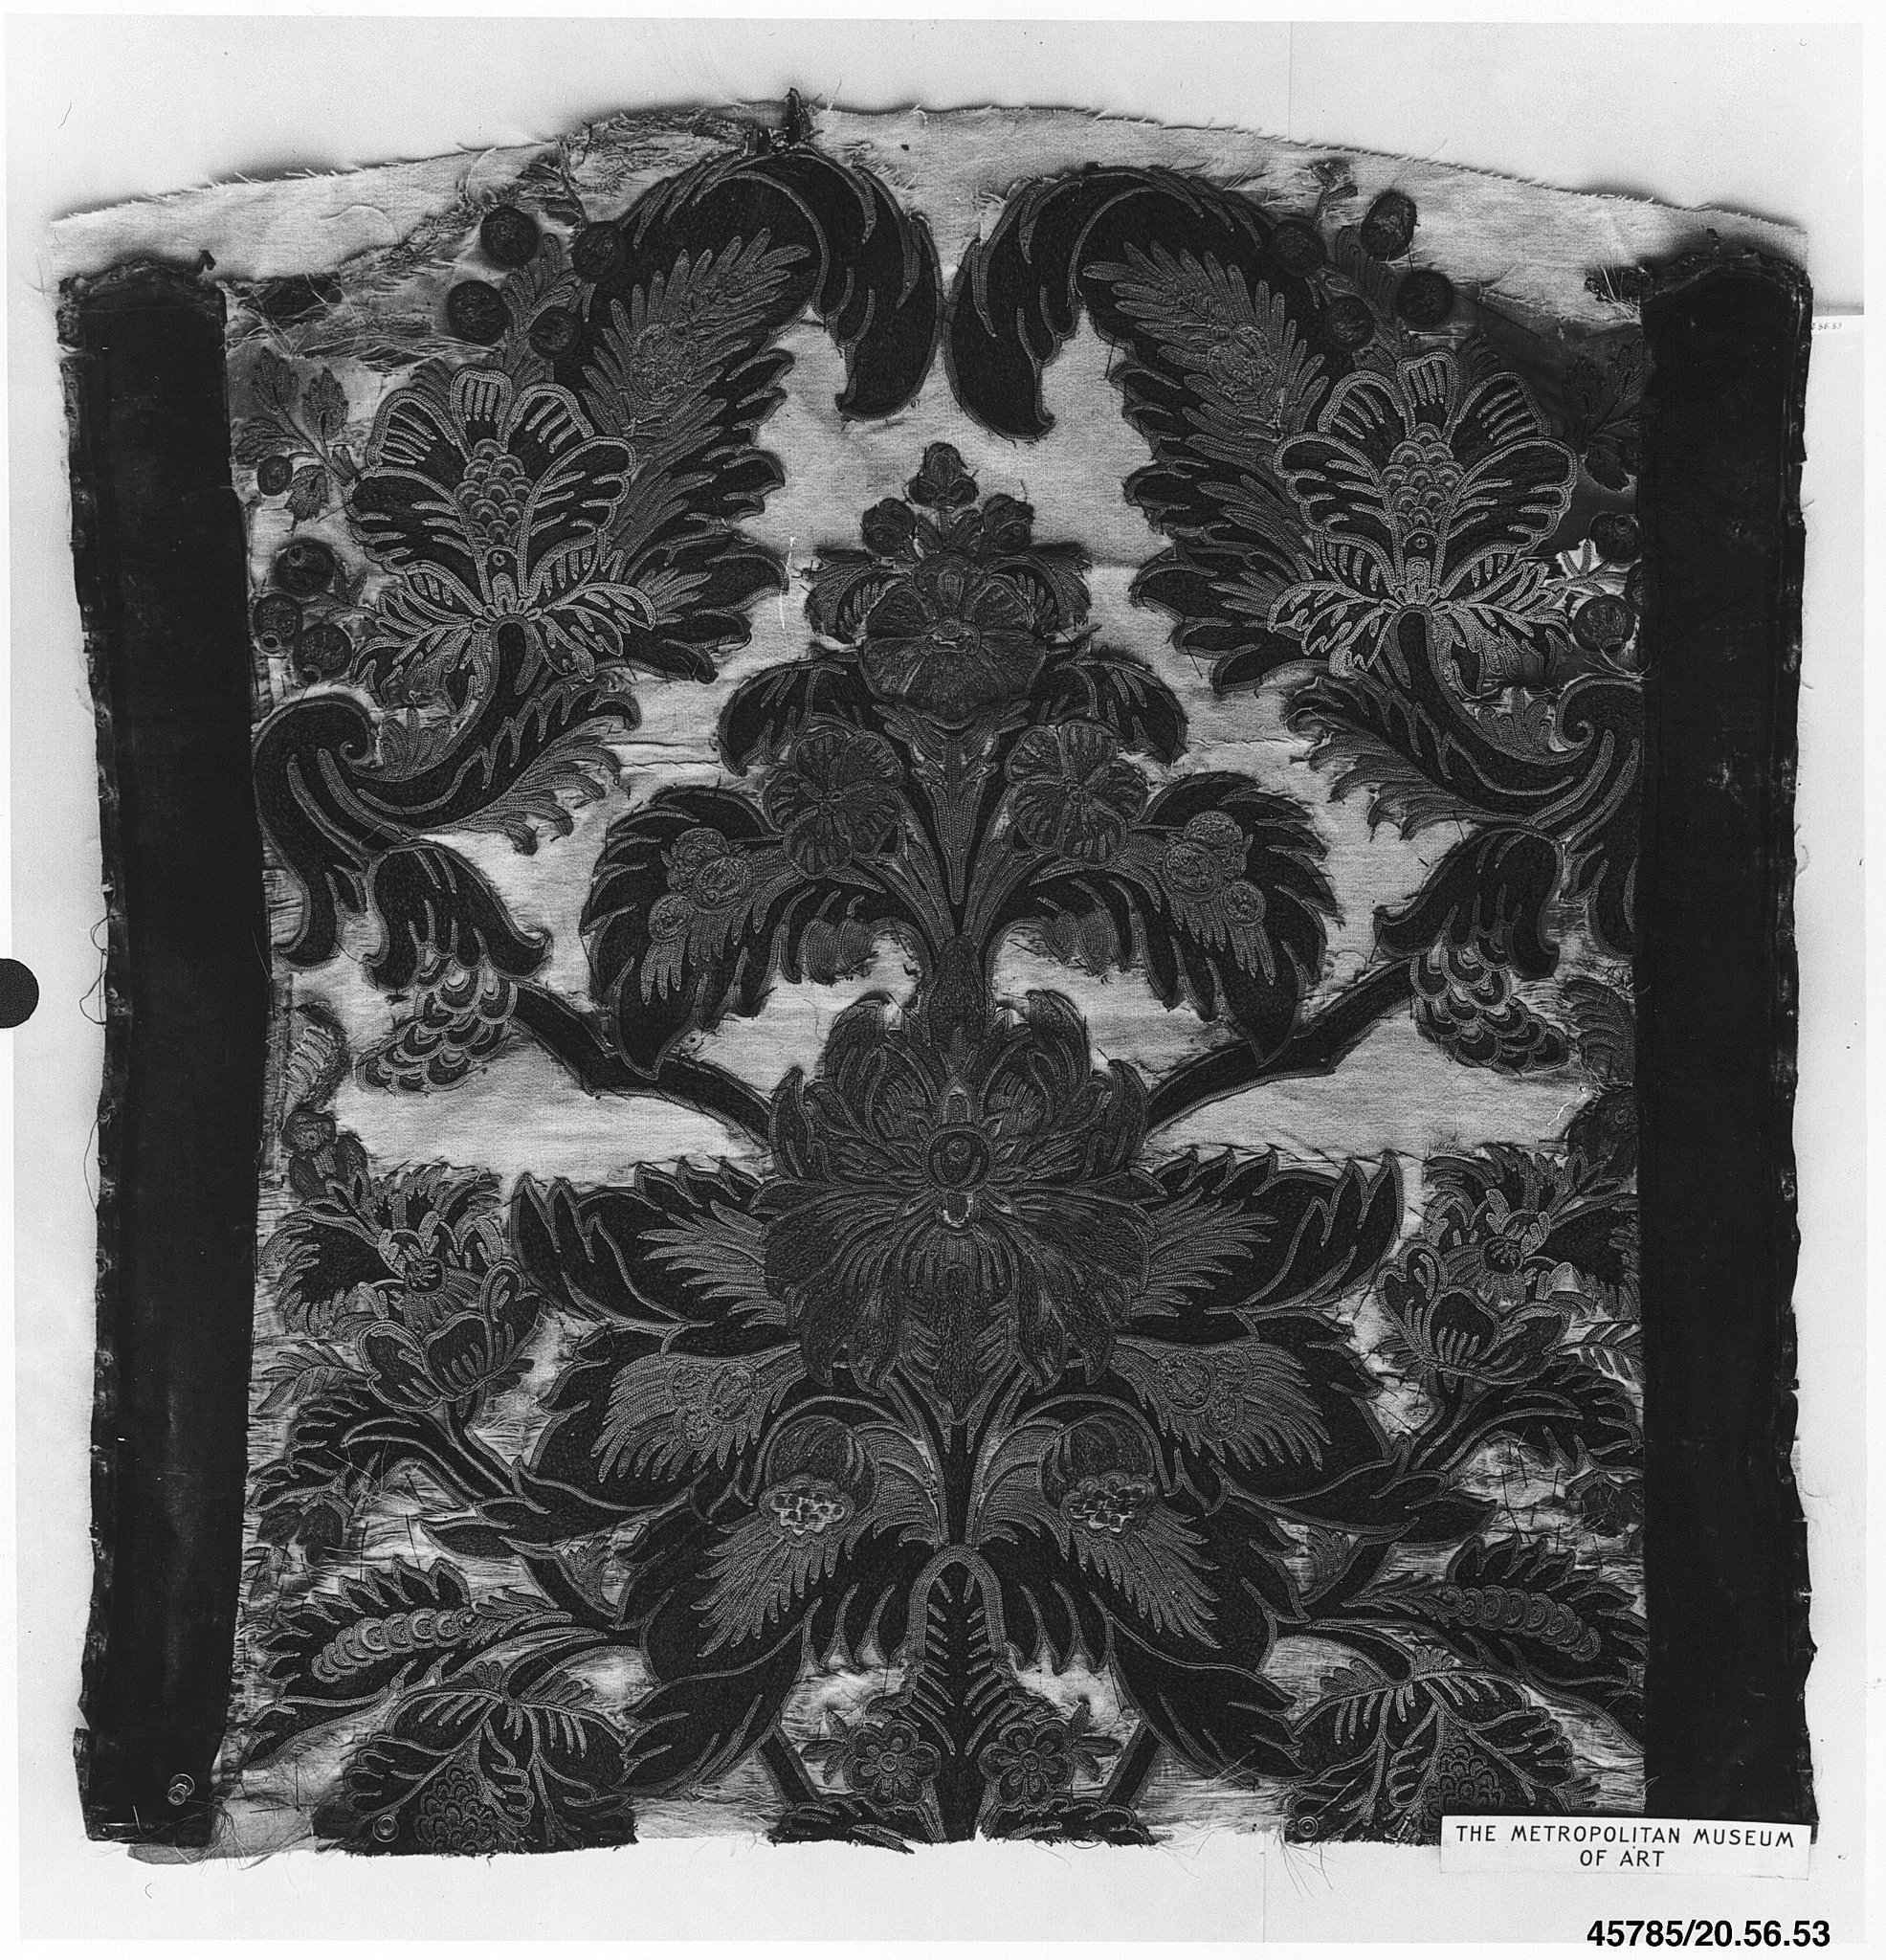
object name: fragment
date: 1643-1715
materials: silk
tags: flowers,leaves